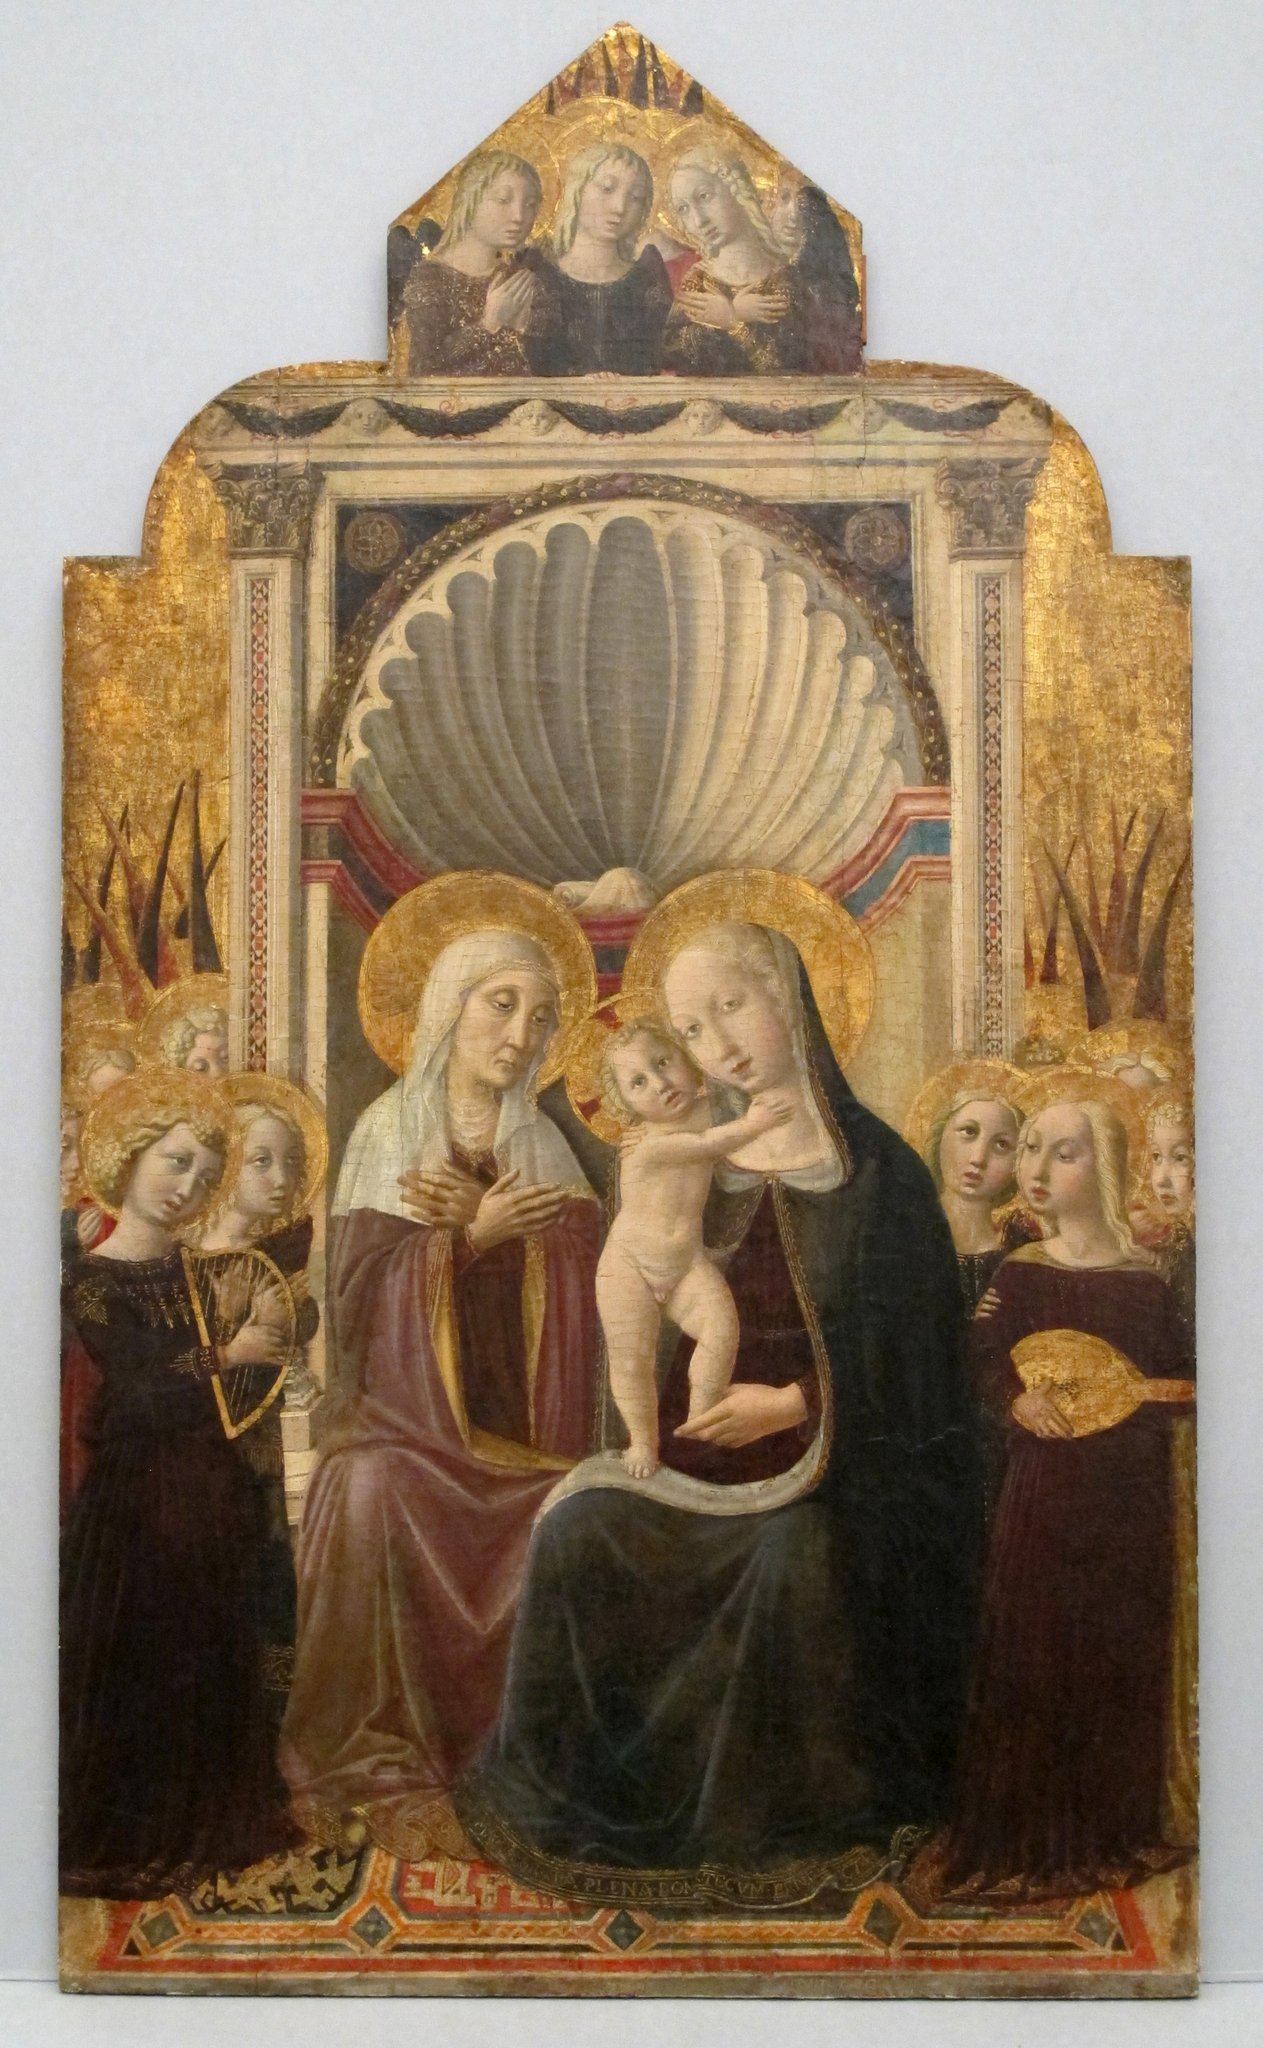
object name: painting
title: Saint Anne and the Virgin and Child Enthroned with Angels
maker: niccolò alunno (niccolò di liberatore)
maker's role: artist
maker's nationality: italian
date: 1458-1461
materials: gold, paint, wood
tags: angels,madonna and child,saint anne